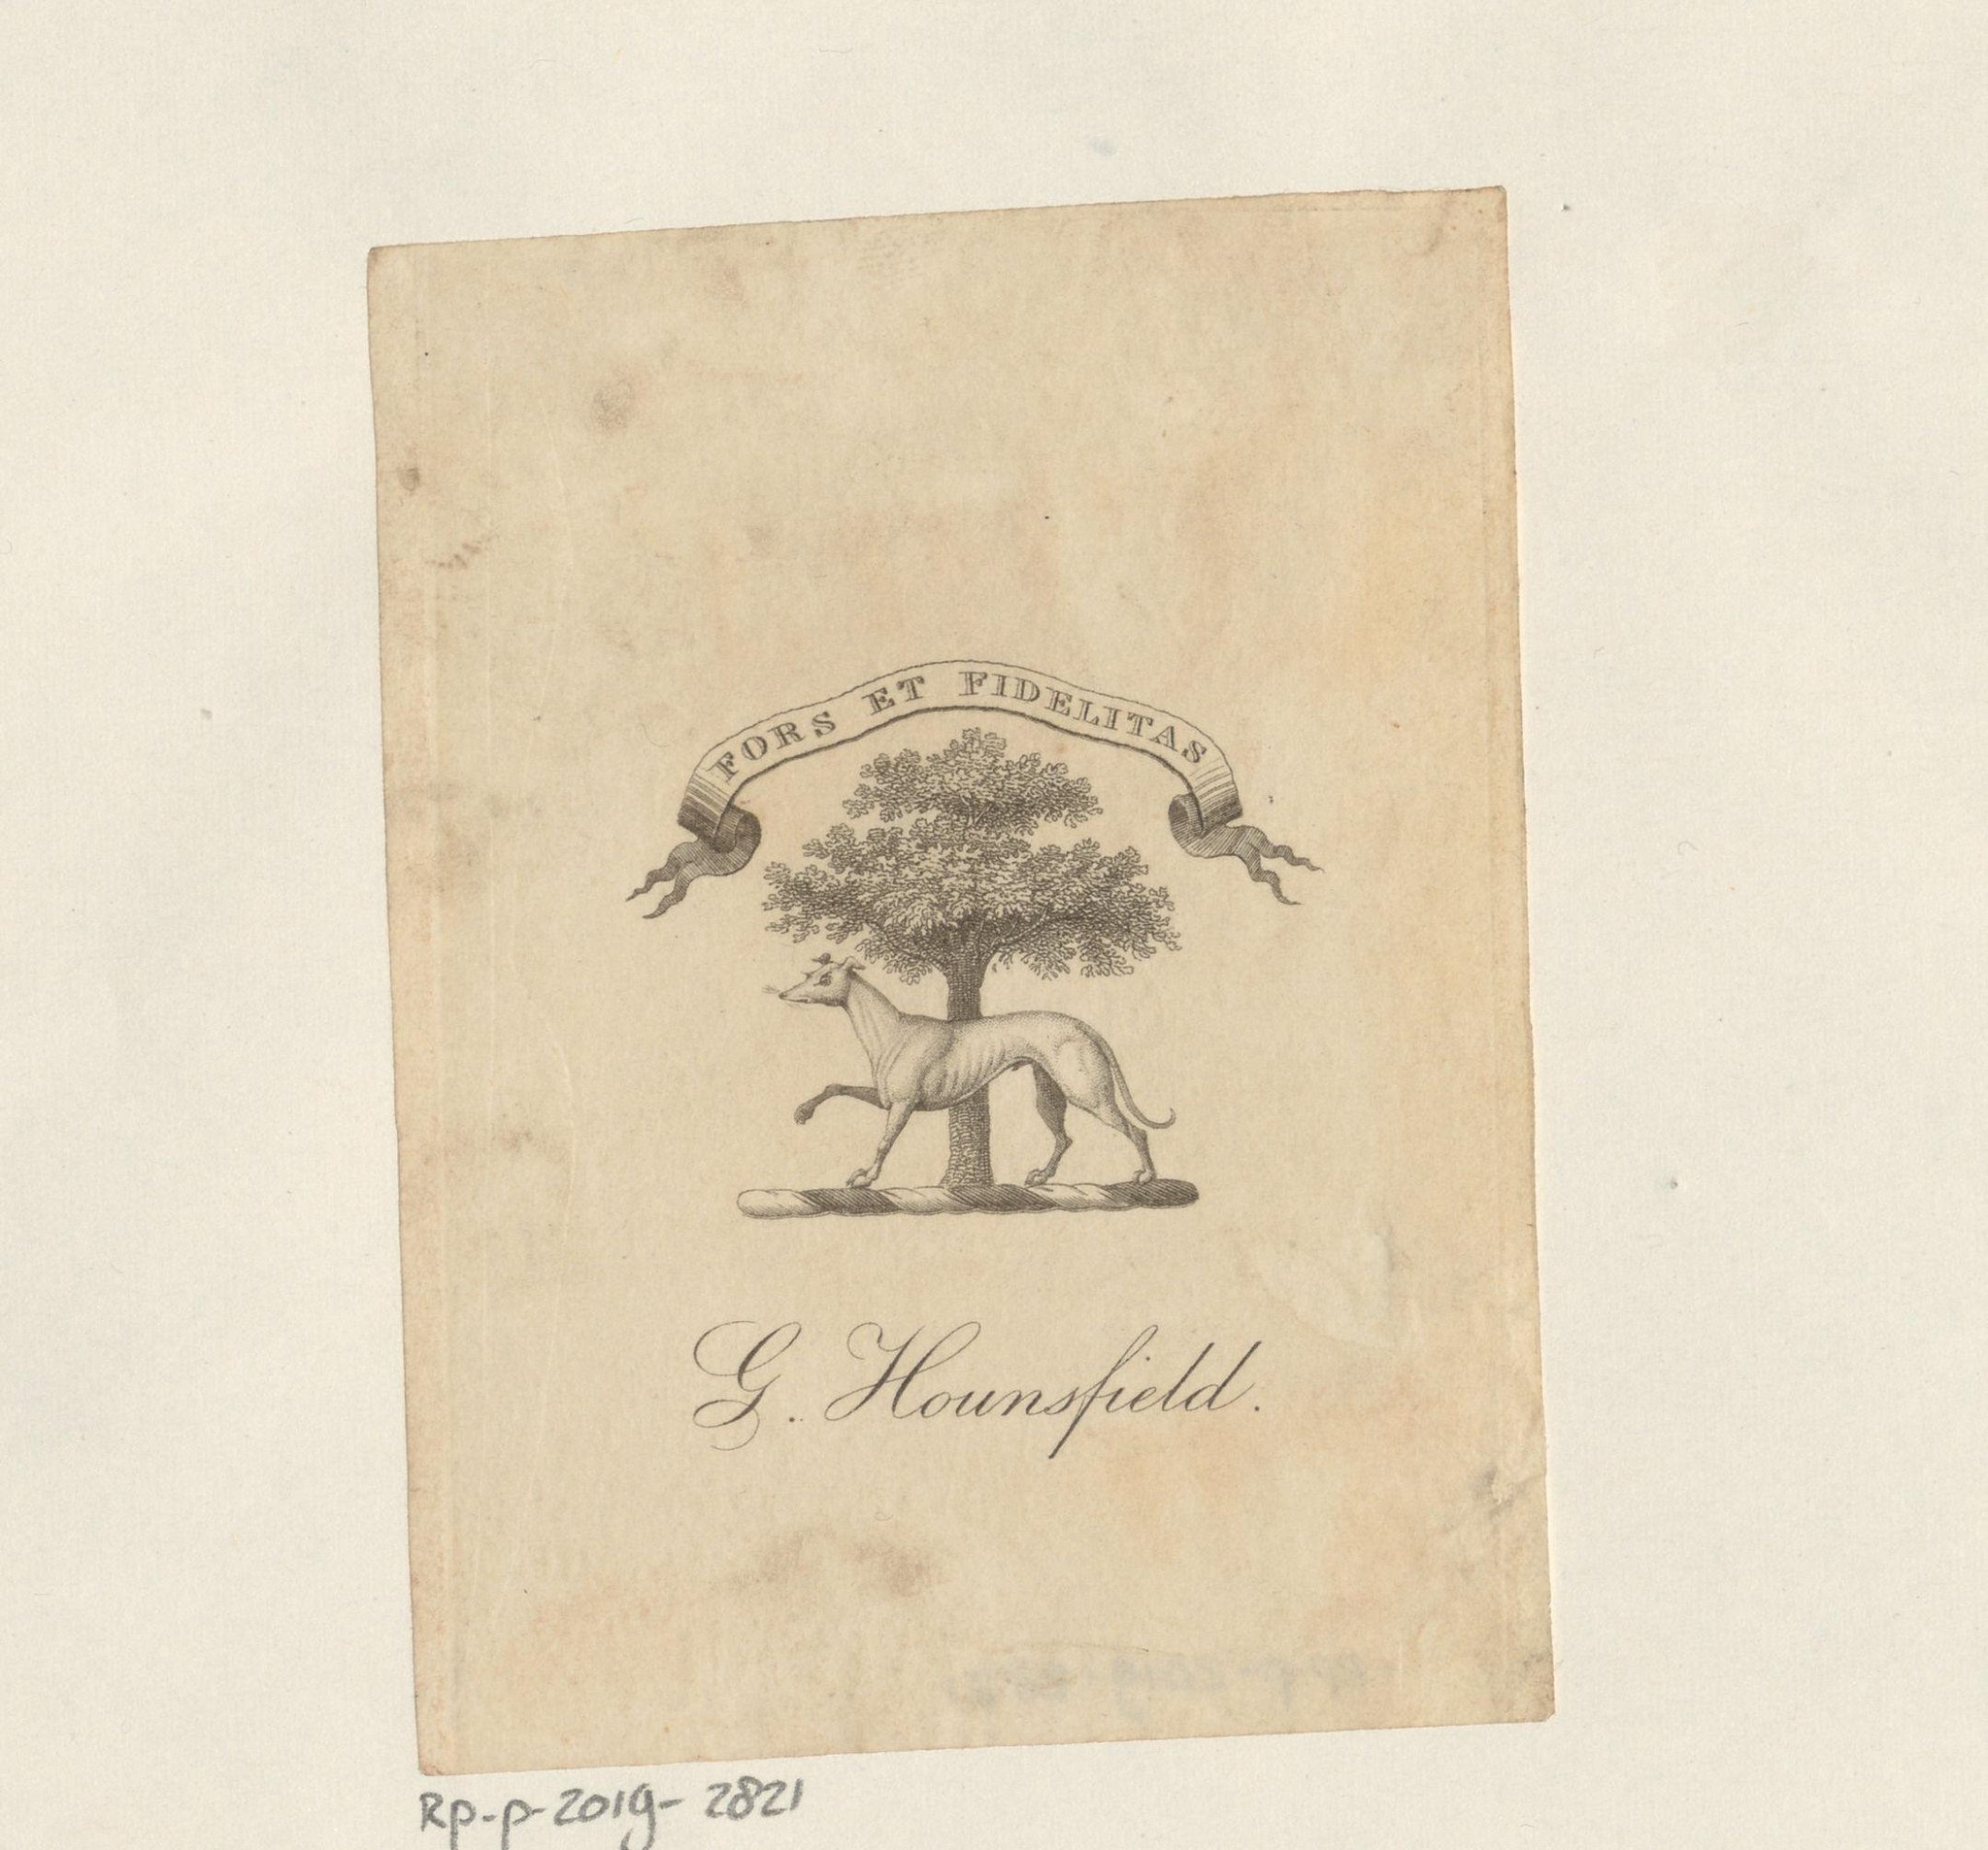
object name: bookplate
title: Pors et fidelitas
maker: Anonymous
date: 1800-1899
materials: paper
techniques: etching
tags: armorial bearing, heraldry